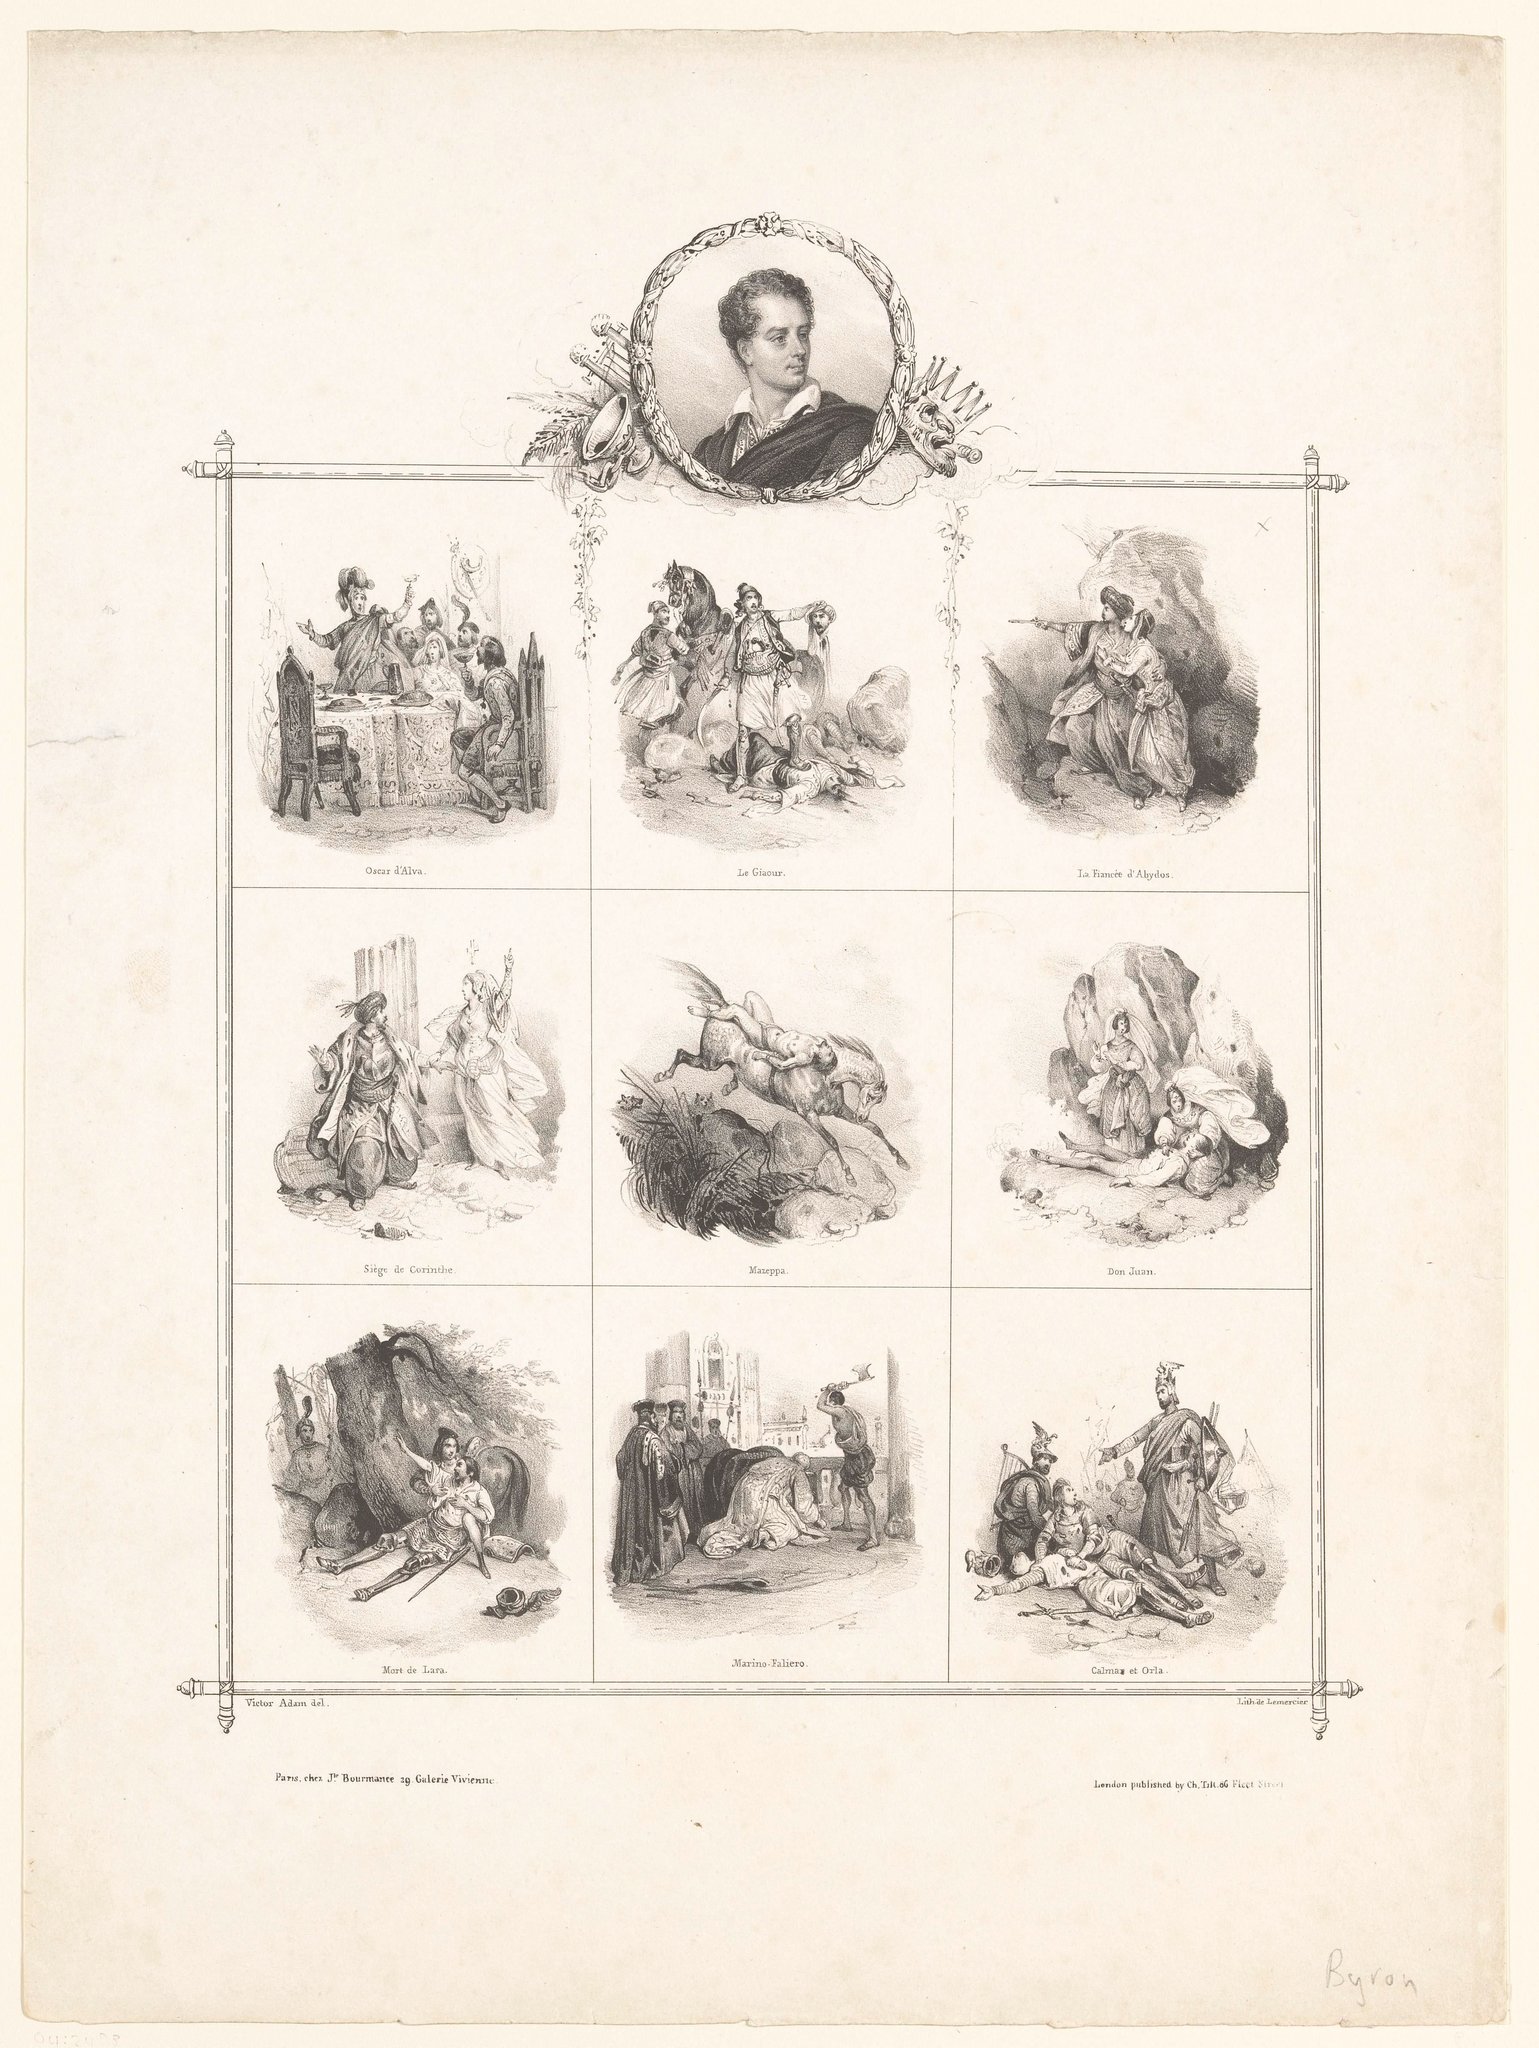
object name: print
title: Portraits d'écrivains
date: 1834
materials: paper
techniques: lithograph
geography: paris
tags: london, lord byron, historical persons, portrait of a writer, (scenes from) specific works of literature (with author, title)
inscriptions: collector's mark: Lugt 2228, annotation: ‘Byron’